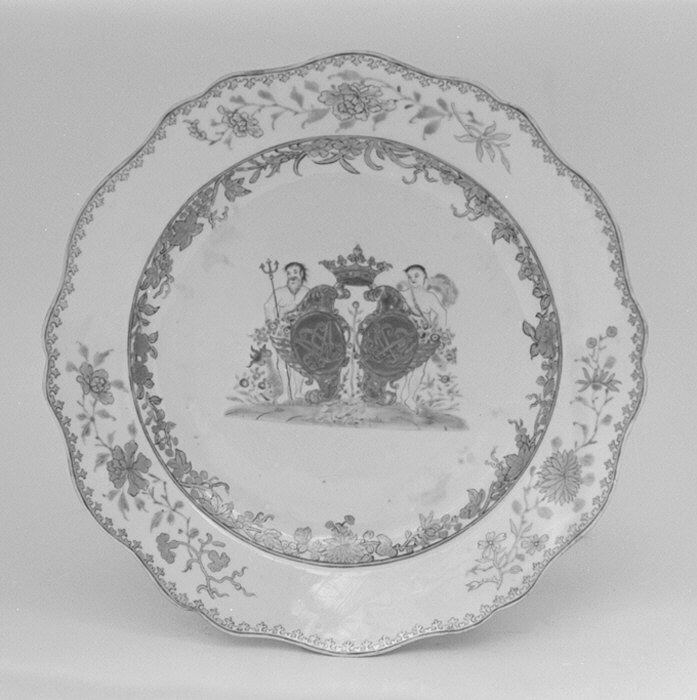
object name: plate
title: Plate (part of a service)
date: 1760-1770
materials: hard paste porcelain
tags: men,coat of arms